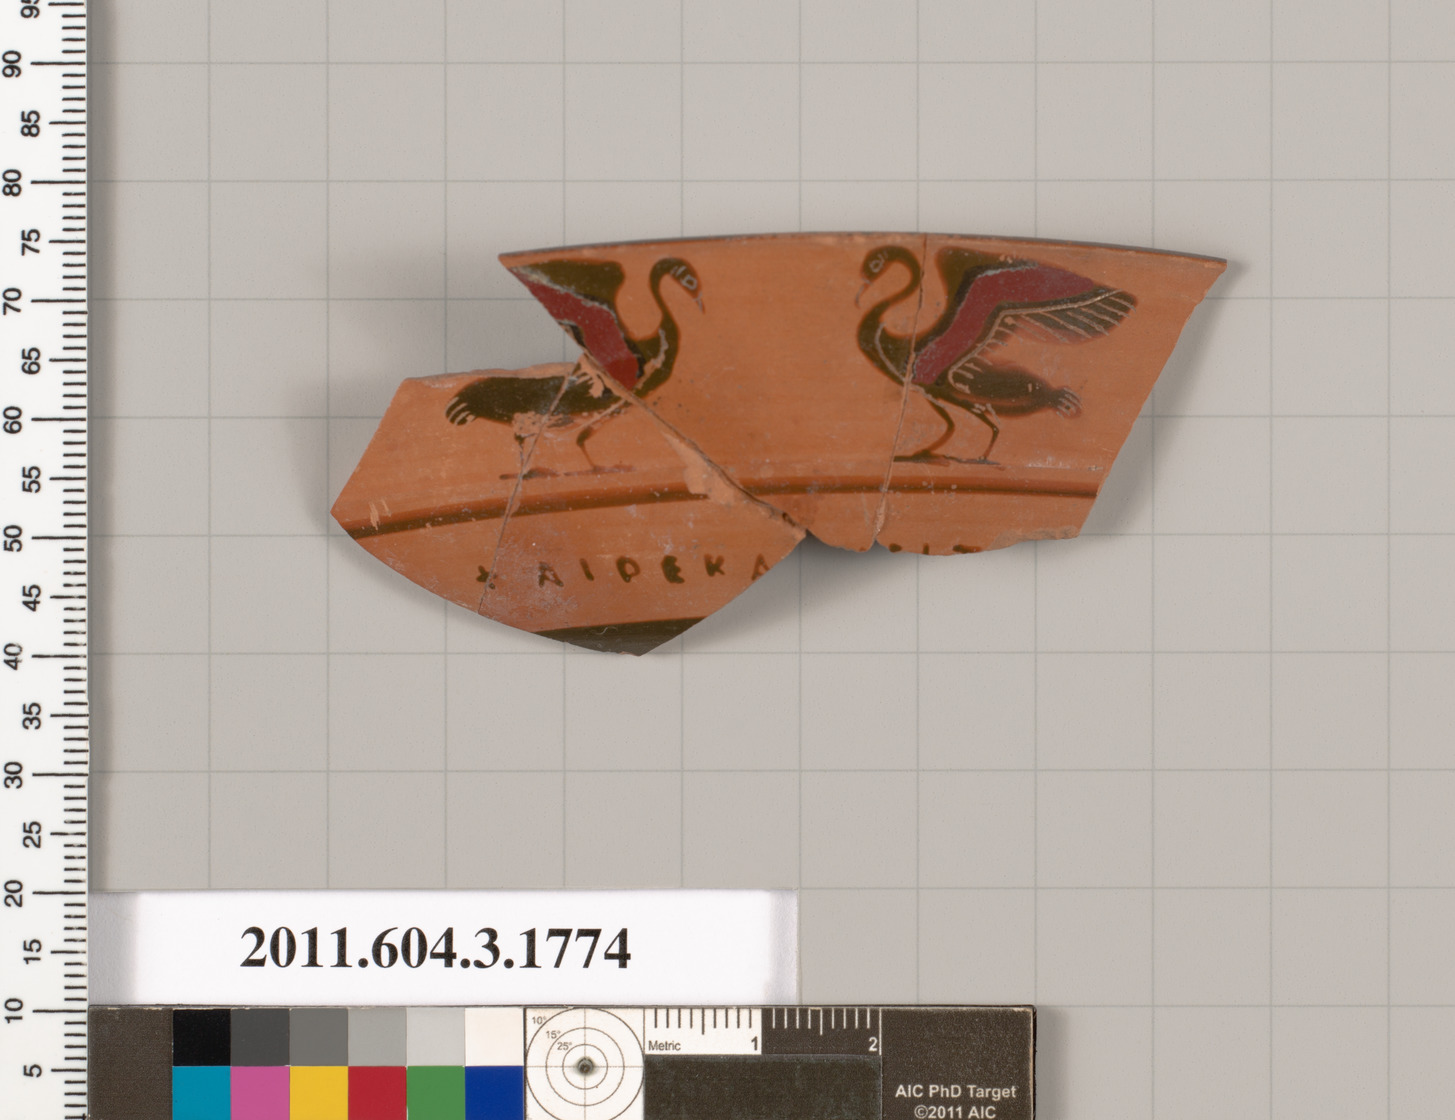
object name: kylix fragment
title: Terracotta rim fragment of a kylix: Lip cup (drinking cup)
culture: greek, attic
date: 560-550 BCE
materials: terracotta